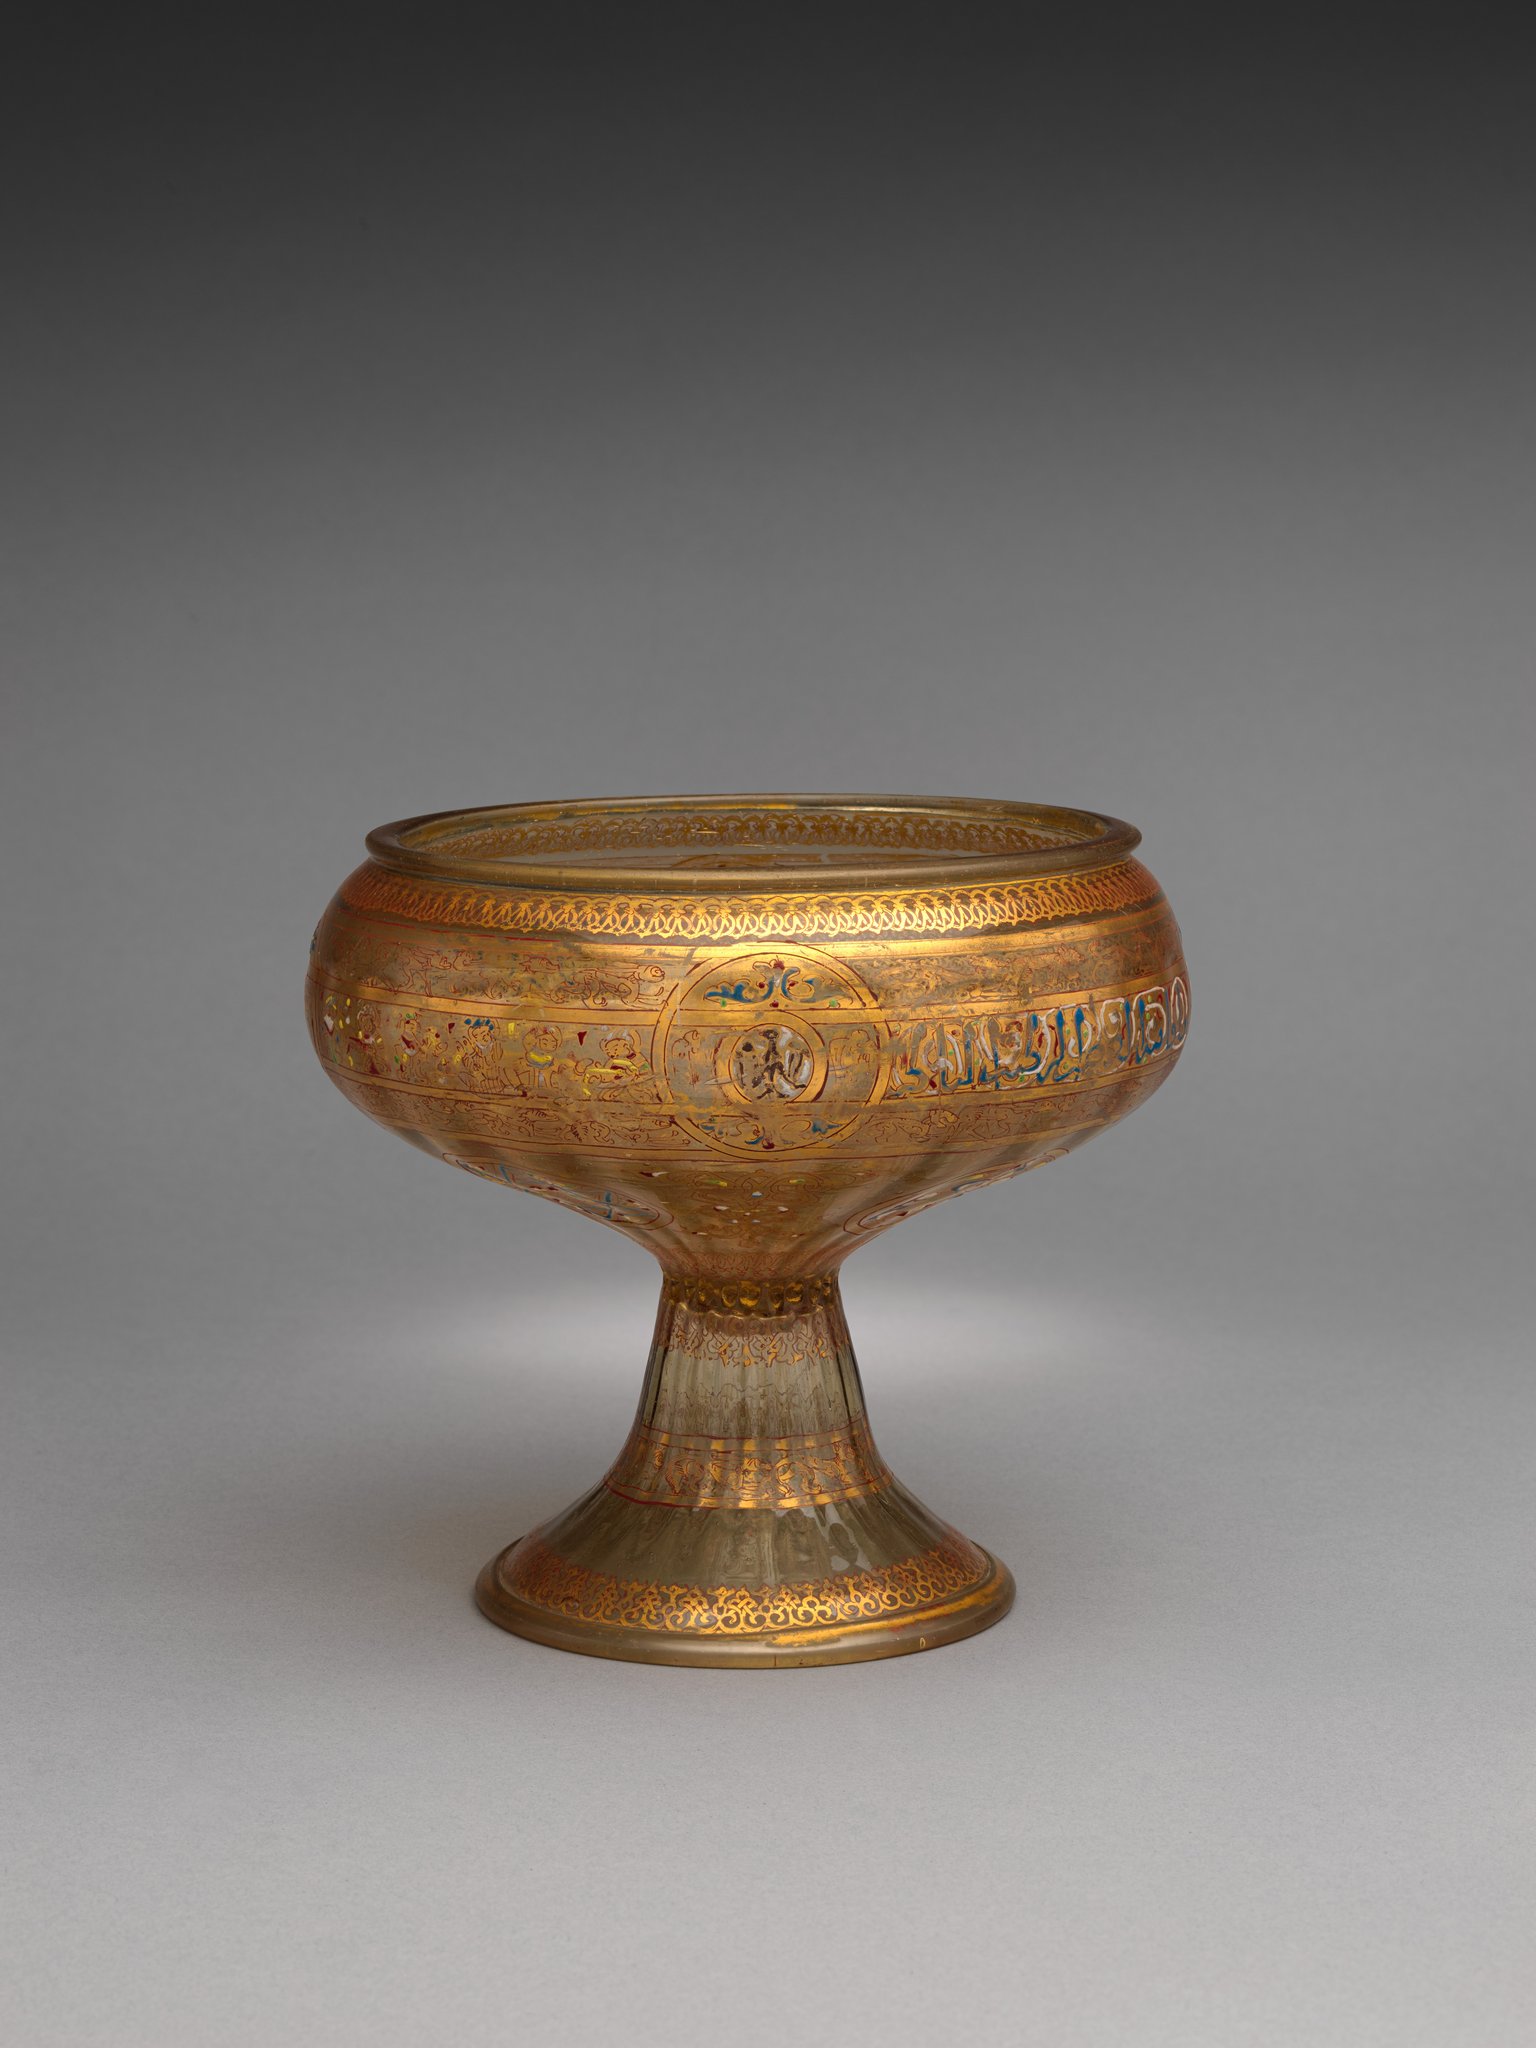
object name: footed bowl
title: Footed Bowl with Eagle Emblem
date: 1234-1266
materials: glass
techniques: glassblowing, enamel, gilding, molding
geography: syria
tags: human figures,eagles,arabic